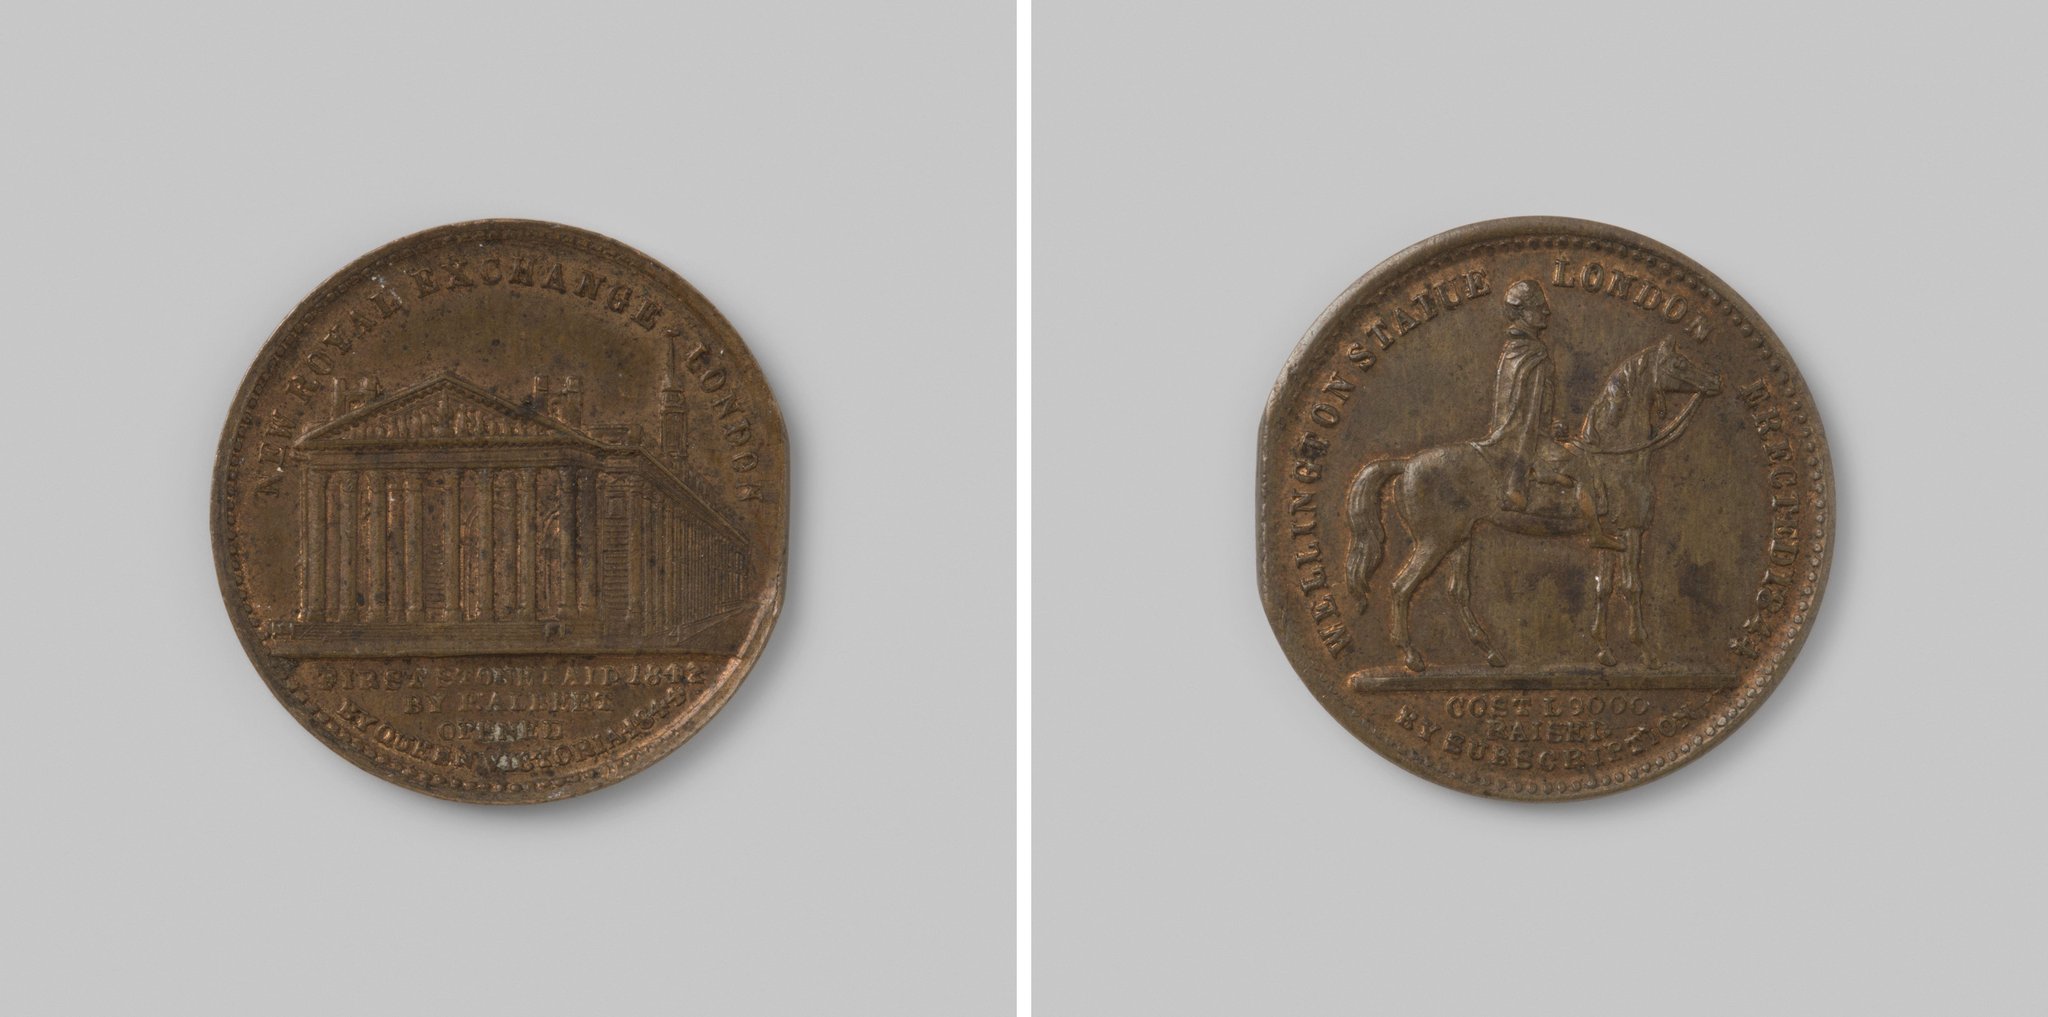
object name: strooipenning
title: Opening van de Nieuwe Beurs te Londen en oprichting van een standbeeld voor de hertog van Wellington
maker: Anonymous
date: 1844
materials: copper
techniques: striking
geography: england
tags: victoria (koningin van het verenigd koninkrijk en keizerin van india), albert (prins van saksen-coburg en gotha), arthur wellesley of wellington, london